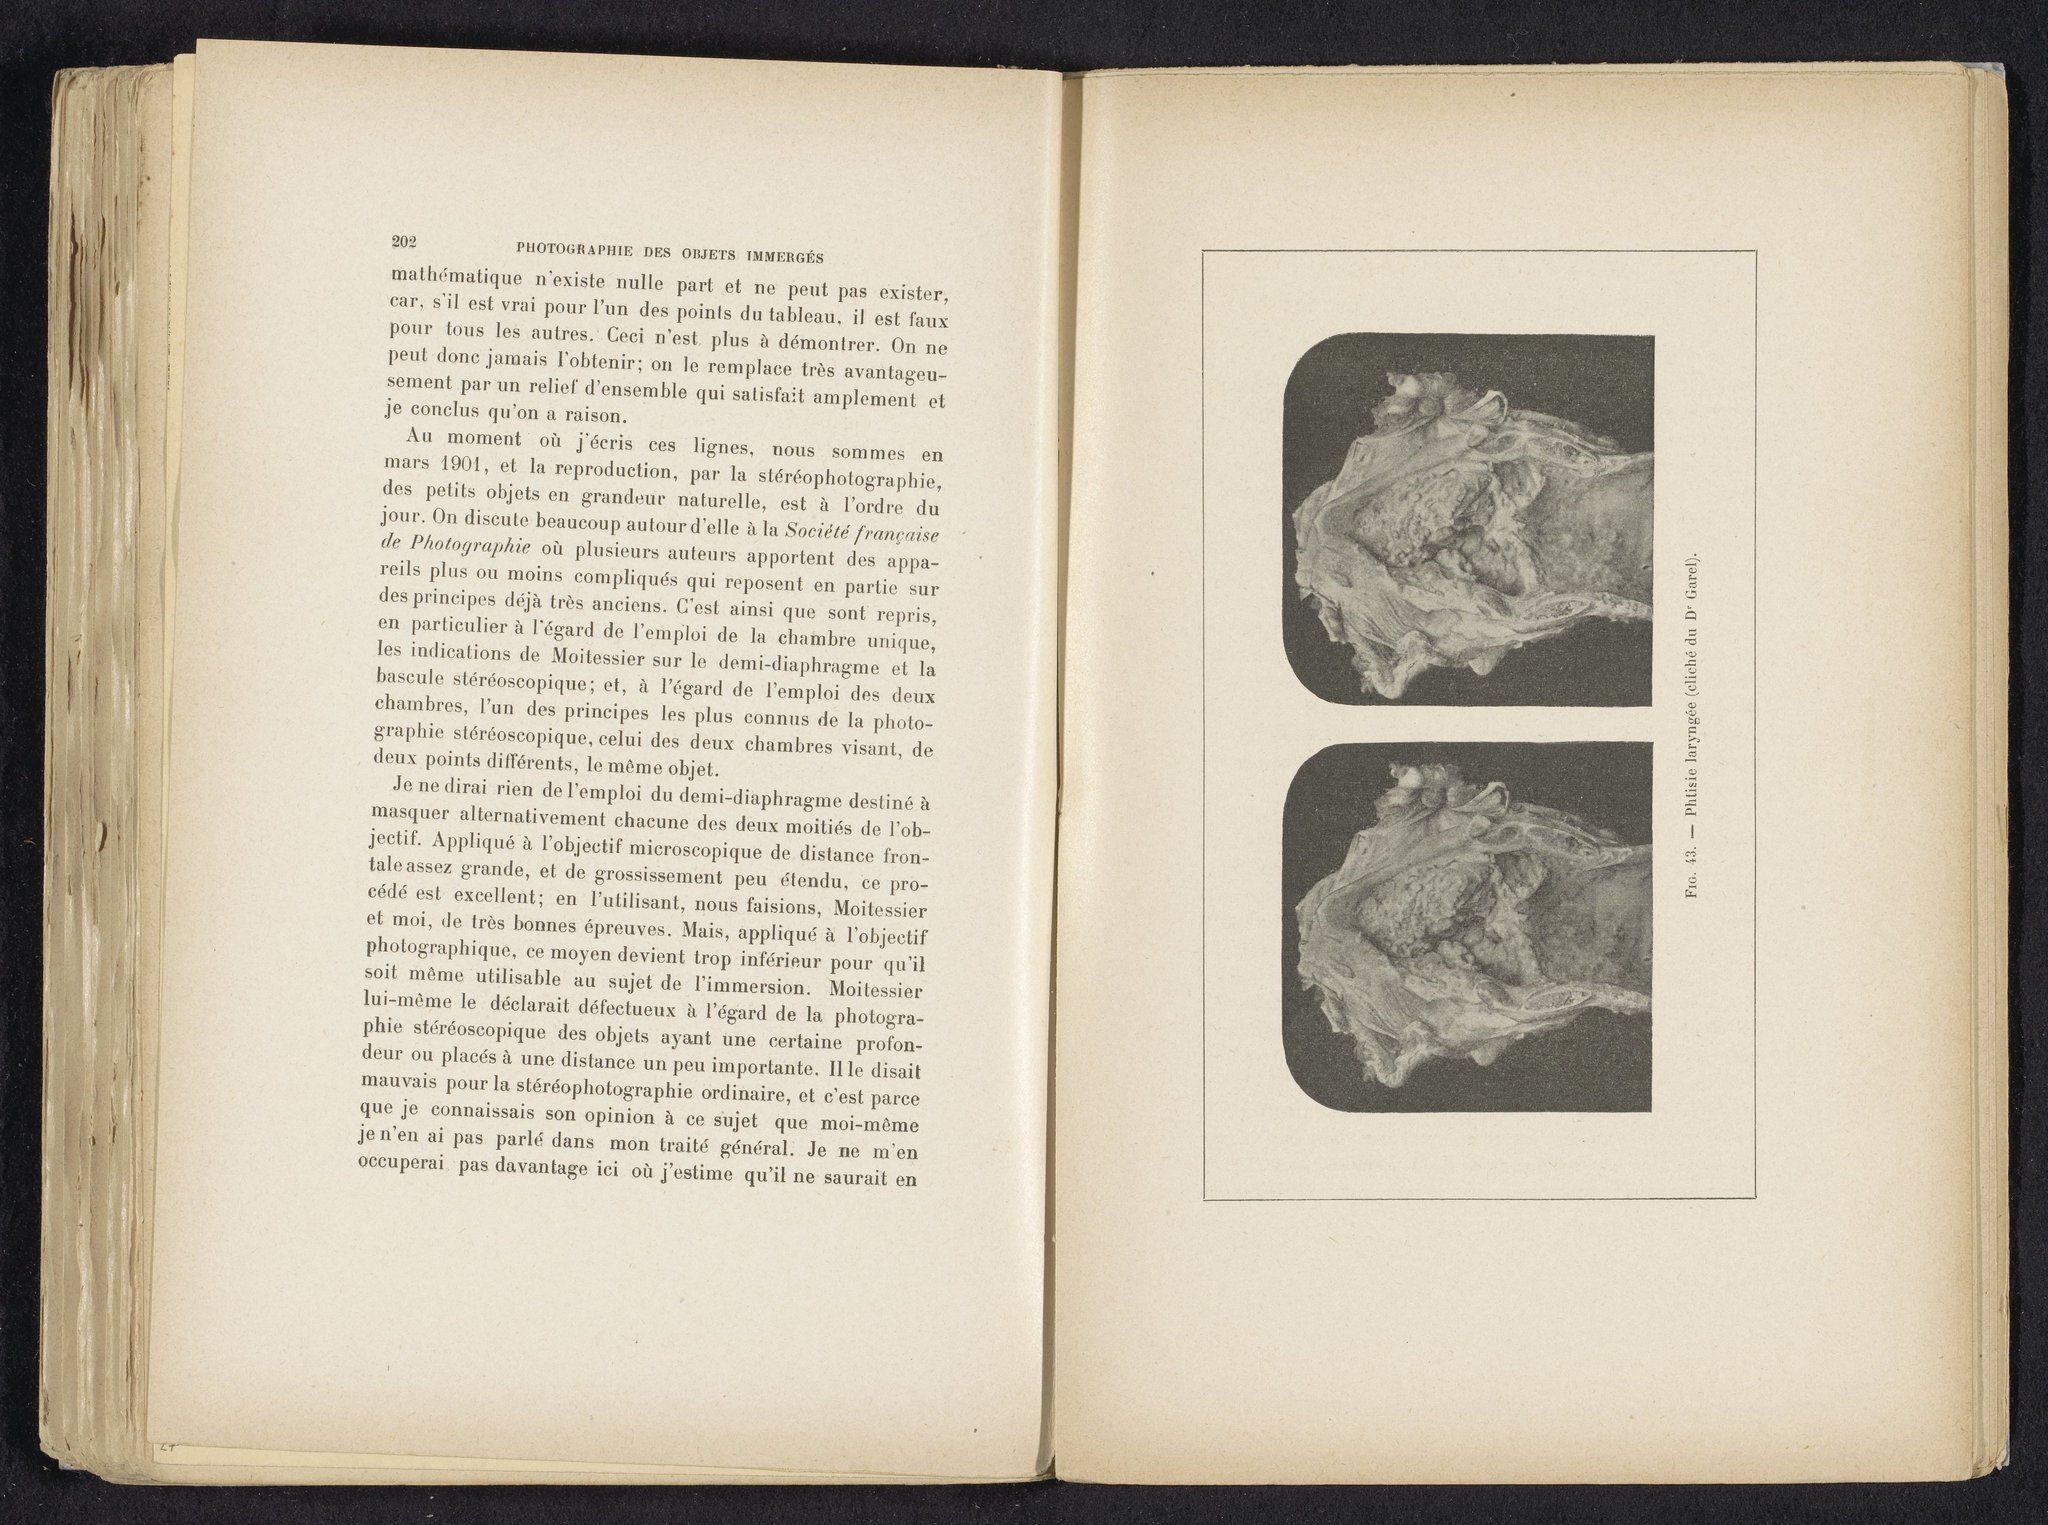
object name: photomechanical print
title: Phtisie laryngée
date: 1891-1901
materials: paper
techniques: autotype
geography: paris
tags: diseases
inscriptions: number: ‘Fig. 43.’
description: Prent in album 'La photographie des objets immergés', 1901.